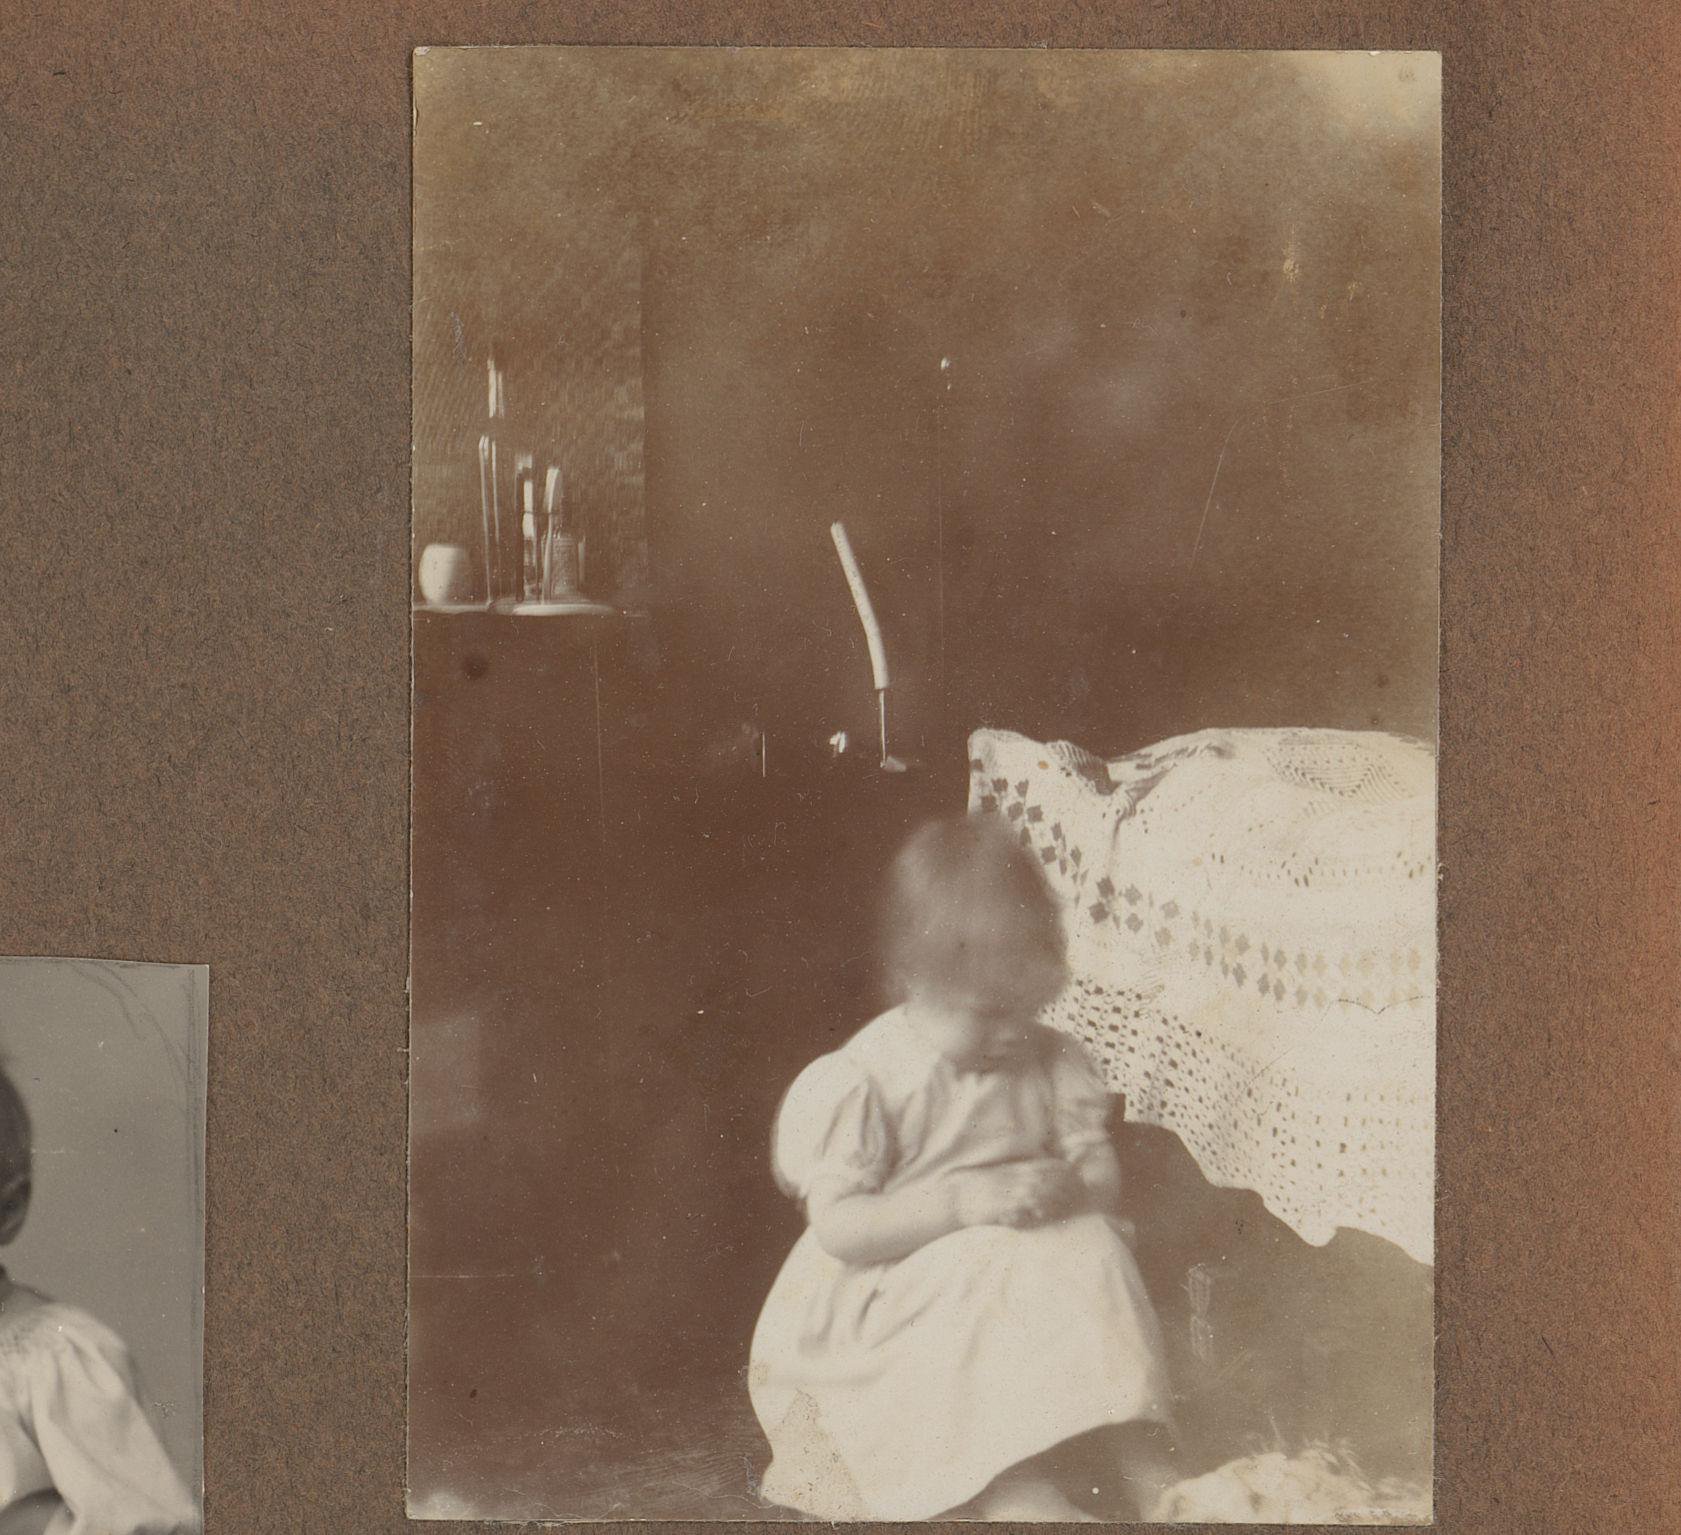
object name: photograph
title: Zittende baby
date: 1870-1920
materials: photographic support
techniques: photography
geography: netherlands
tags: netherlands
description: Foto op bruin albumblad 43 van familiealbum van Alphons Diepenbrock.